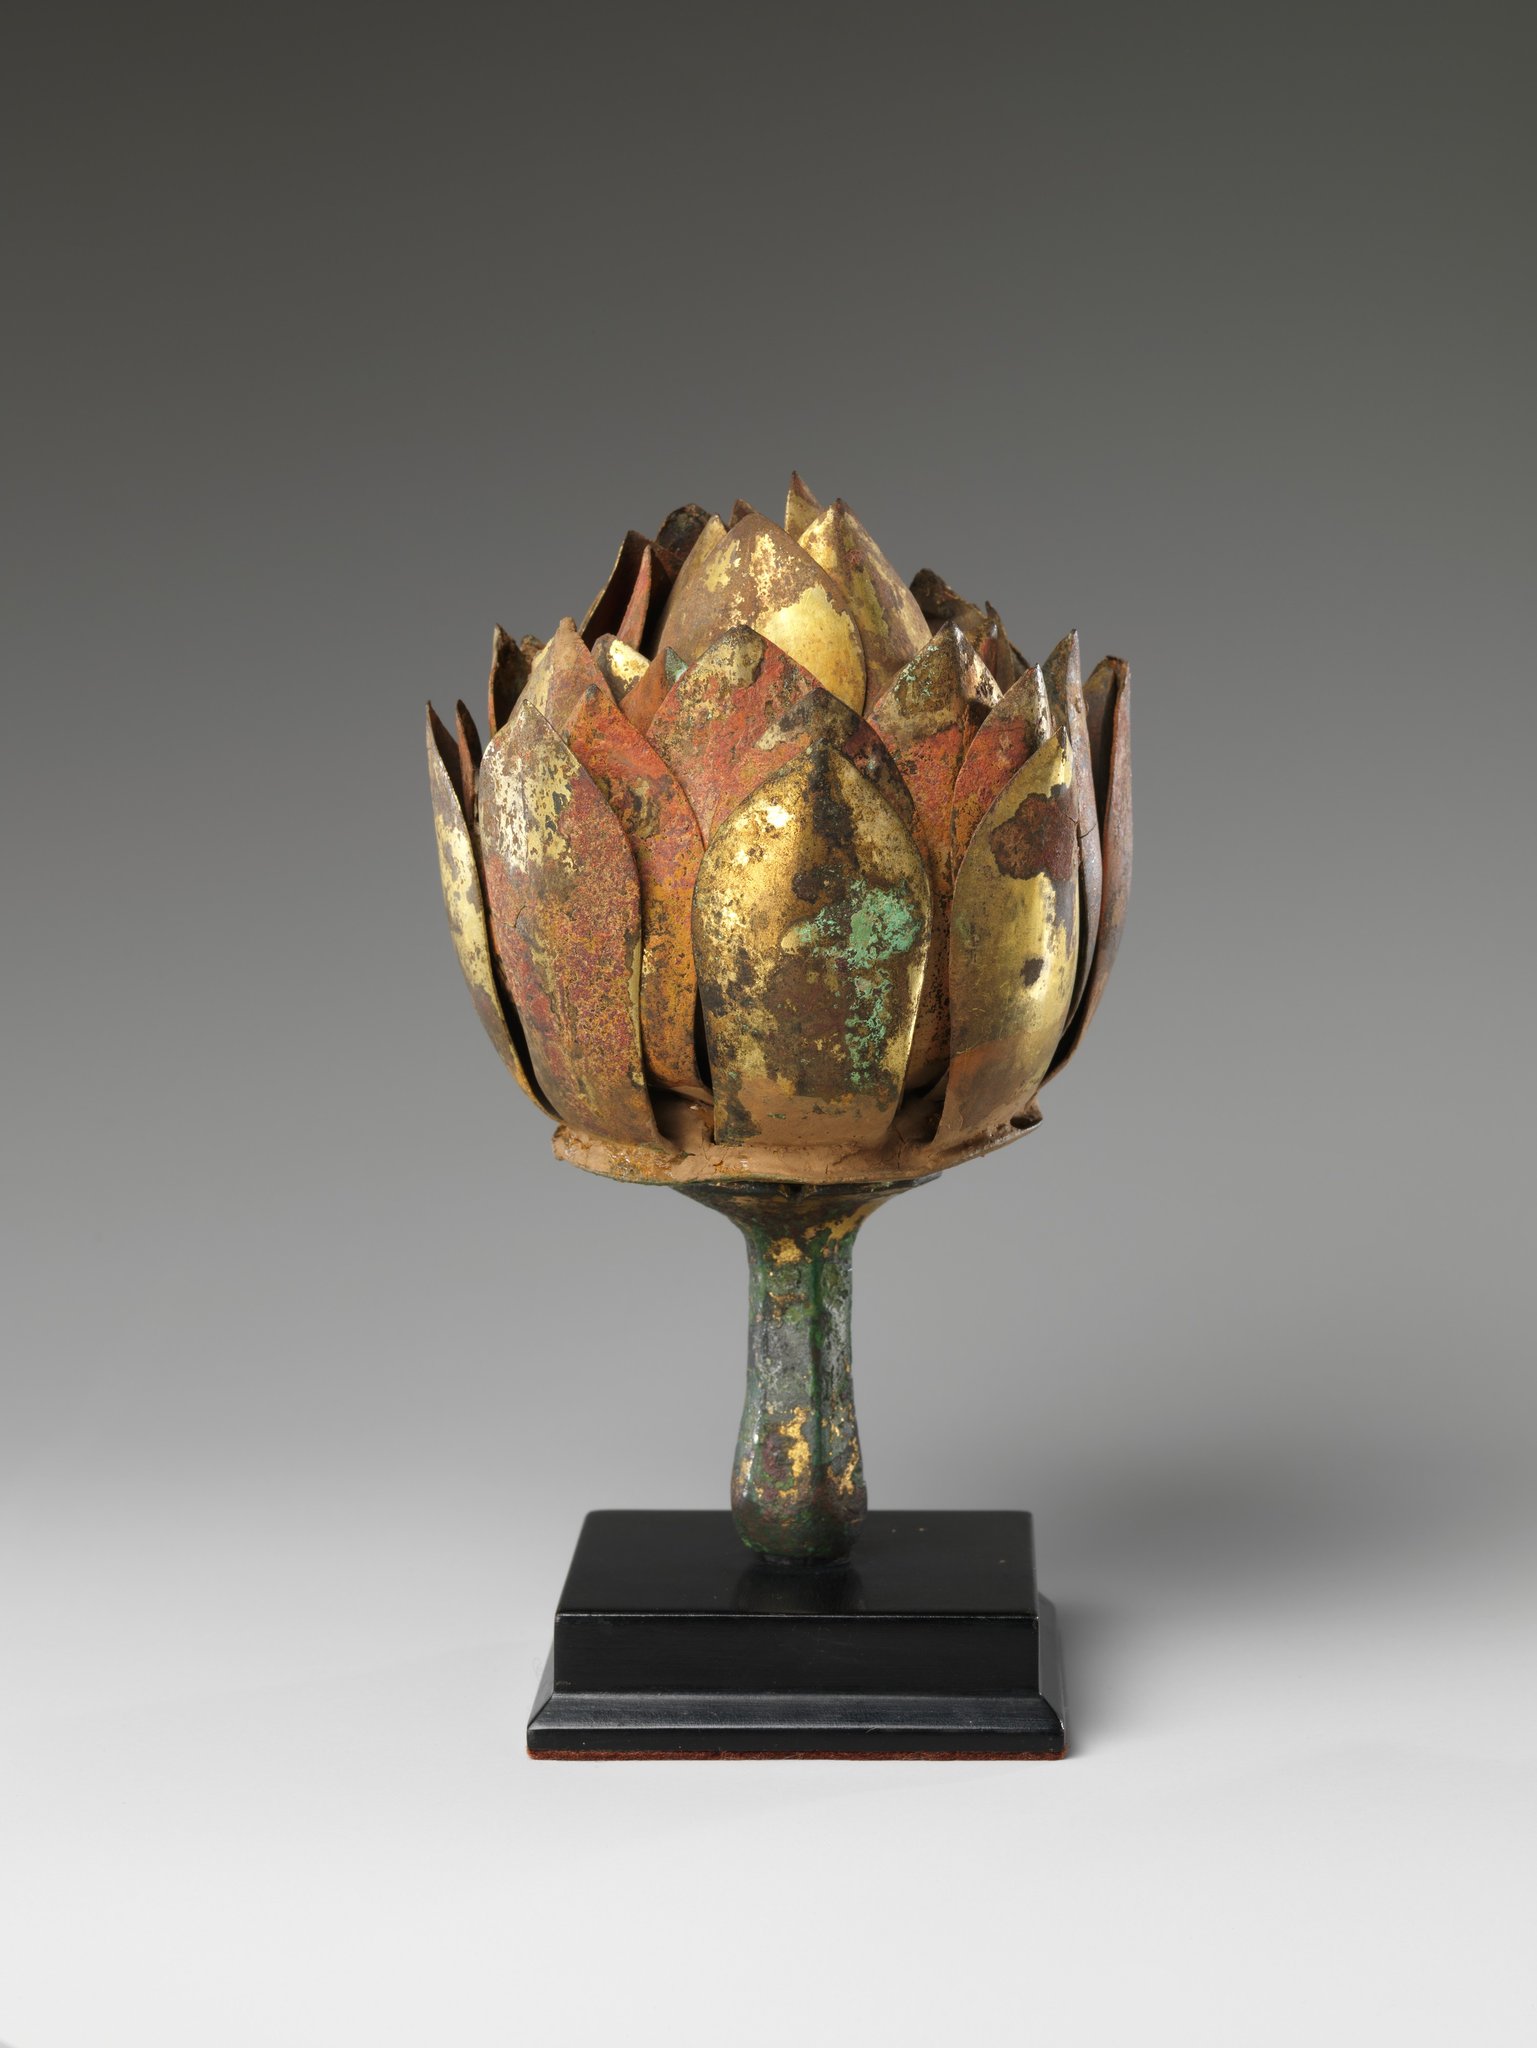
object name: figurine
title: Lotus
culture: chinese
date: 618-907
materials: gilt bronze